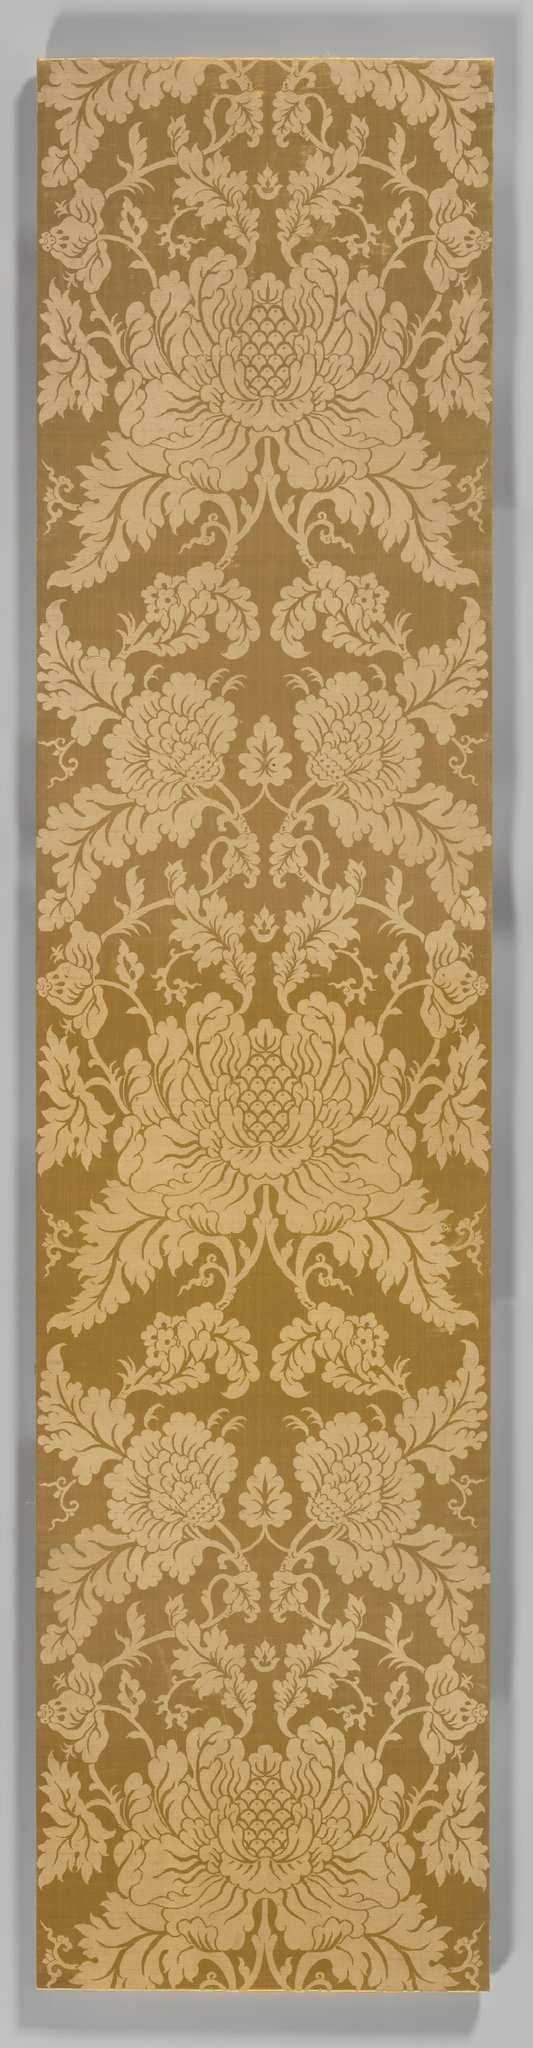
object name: silk textile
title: Wandbespanning van geel zijden damasten met symmetrisch patroon van twee opgaande golvende ranken met onder andere pioenvormige bloemen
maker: Anonymous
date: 1700-1725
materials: silk, wood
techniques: damask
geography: france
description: Geel zijden damasten wandbespanning. Symmetrisch patroon van twee opgaande golvende ranken waaraan grote pioenvormige bloemen met geschubtd hart; kleinere bloemen zijn paarsgewijs geplaatst, evenals bloemknoppen, gevederde bladeren en arabeskrankjes, die eindigen in wolkenbanden. Patroon van keperstreep, fond van satijnbinding. Afkomstig uit het pand Voorstraat 140 te Dordrecht. Eén baan heeft aan de onderkant wat waterschade.